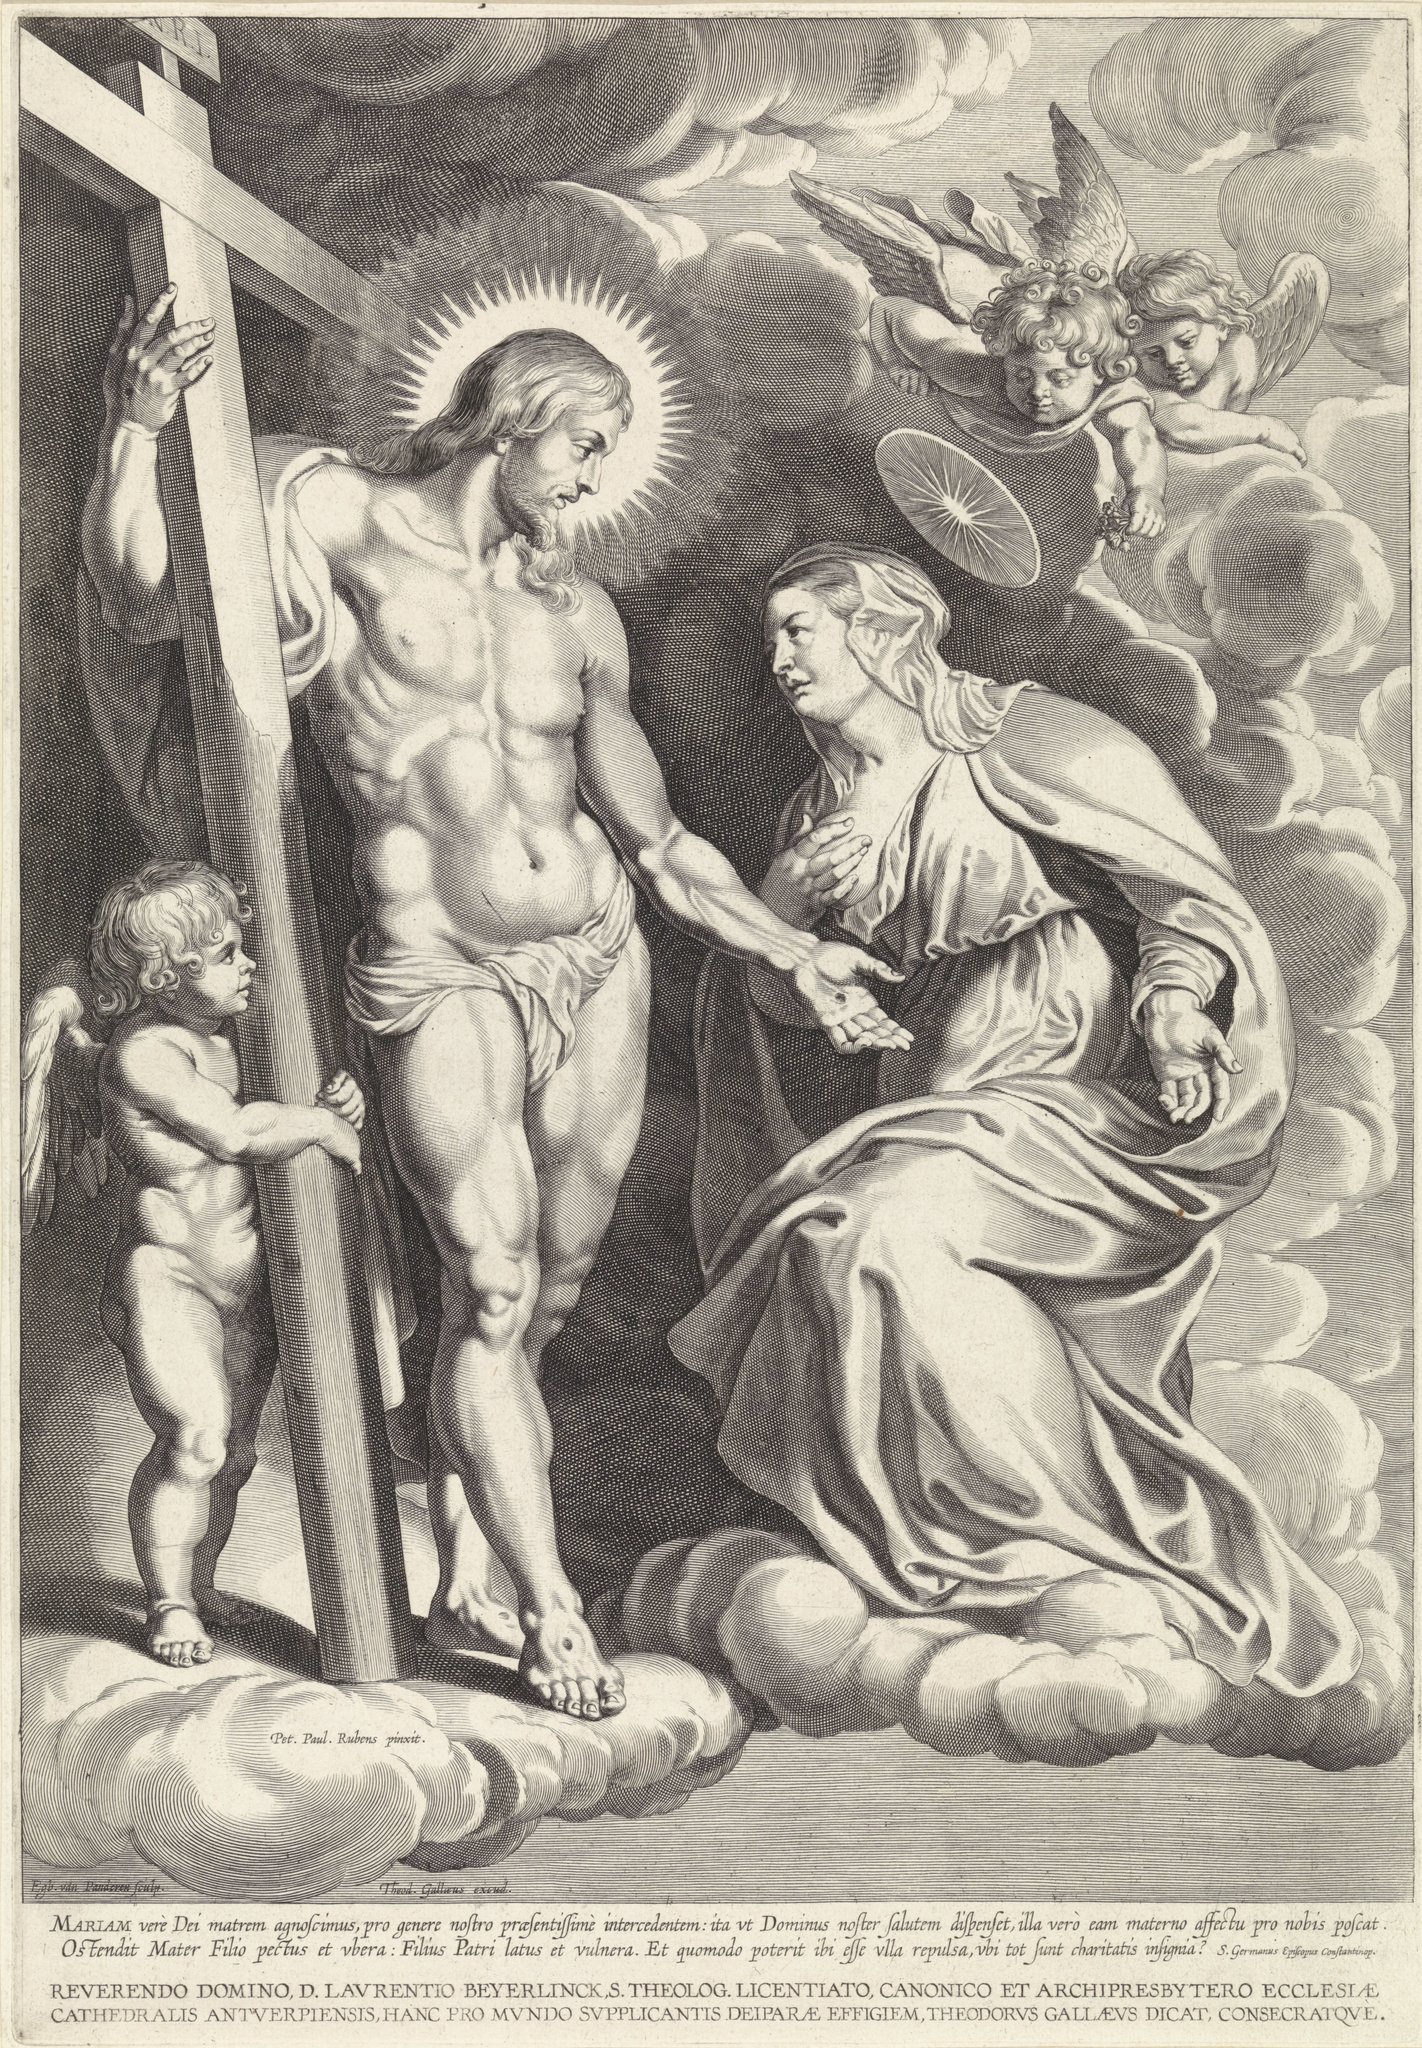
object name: print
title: Maria bij Christus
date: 1590-1637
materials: paper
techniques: engraving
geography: antwerp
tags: mary interceding (with christ), 'maria mediatrix' (sometimes mary showing her breasts)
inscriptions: collector's mark: Lugt 240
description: Christus ontvangt Maria in de hemel. Hij houdt zijn kruis vast en toont zijn stigmata. Maria knielt voor hem en houdt haar hand tegen haar borst. Drie engelen kijken toe, één van hen houdt het kruis vast. In de marge twee maal tweeregelig onderschrift in het Latijn.